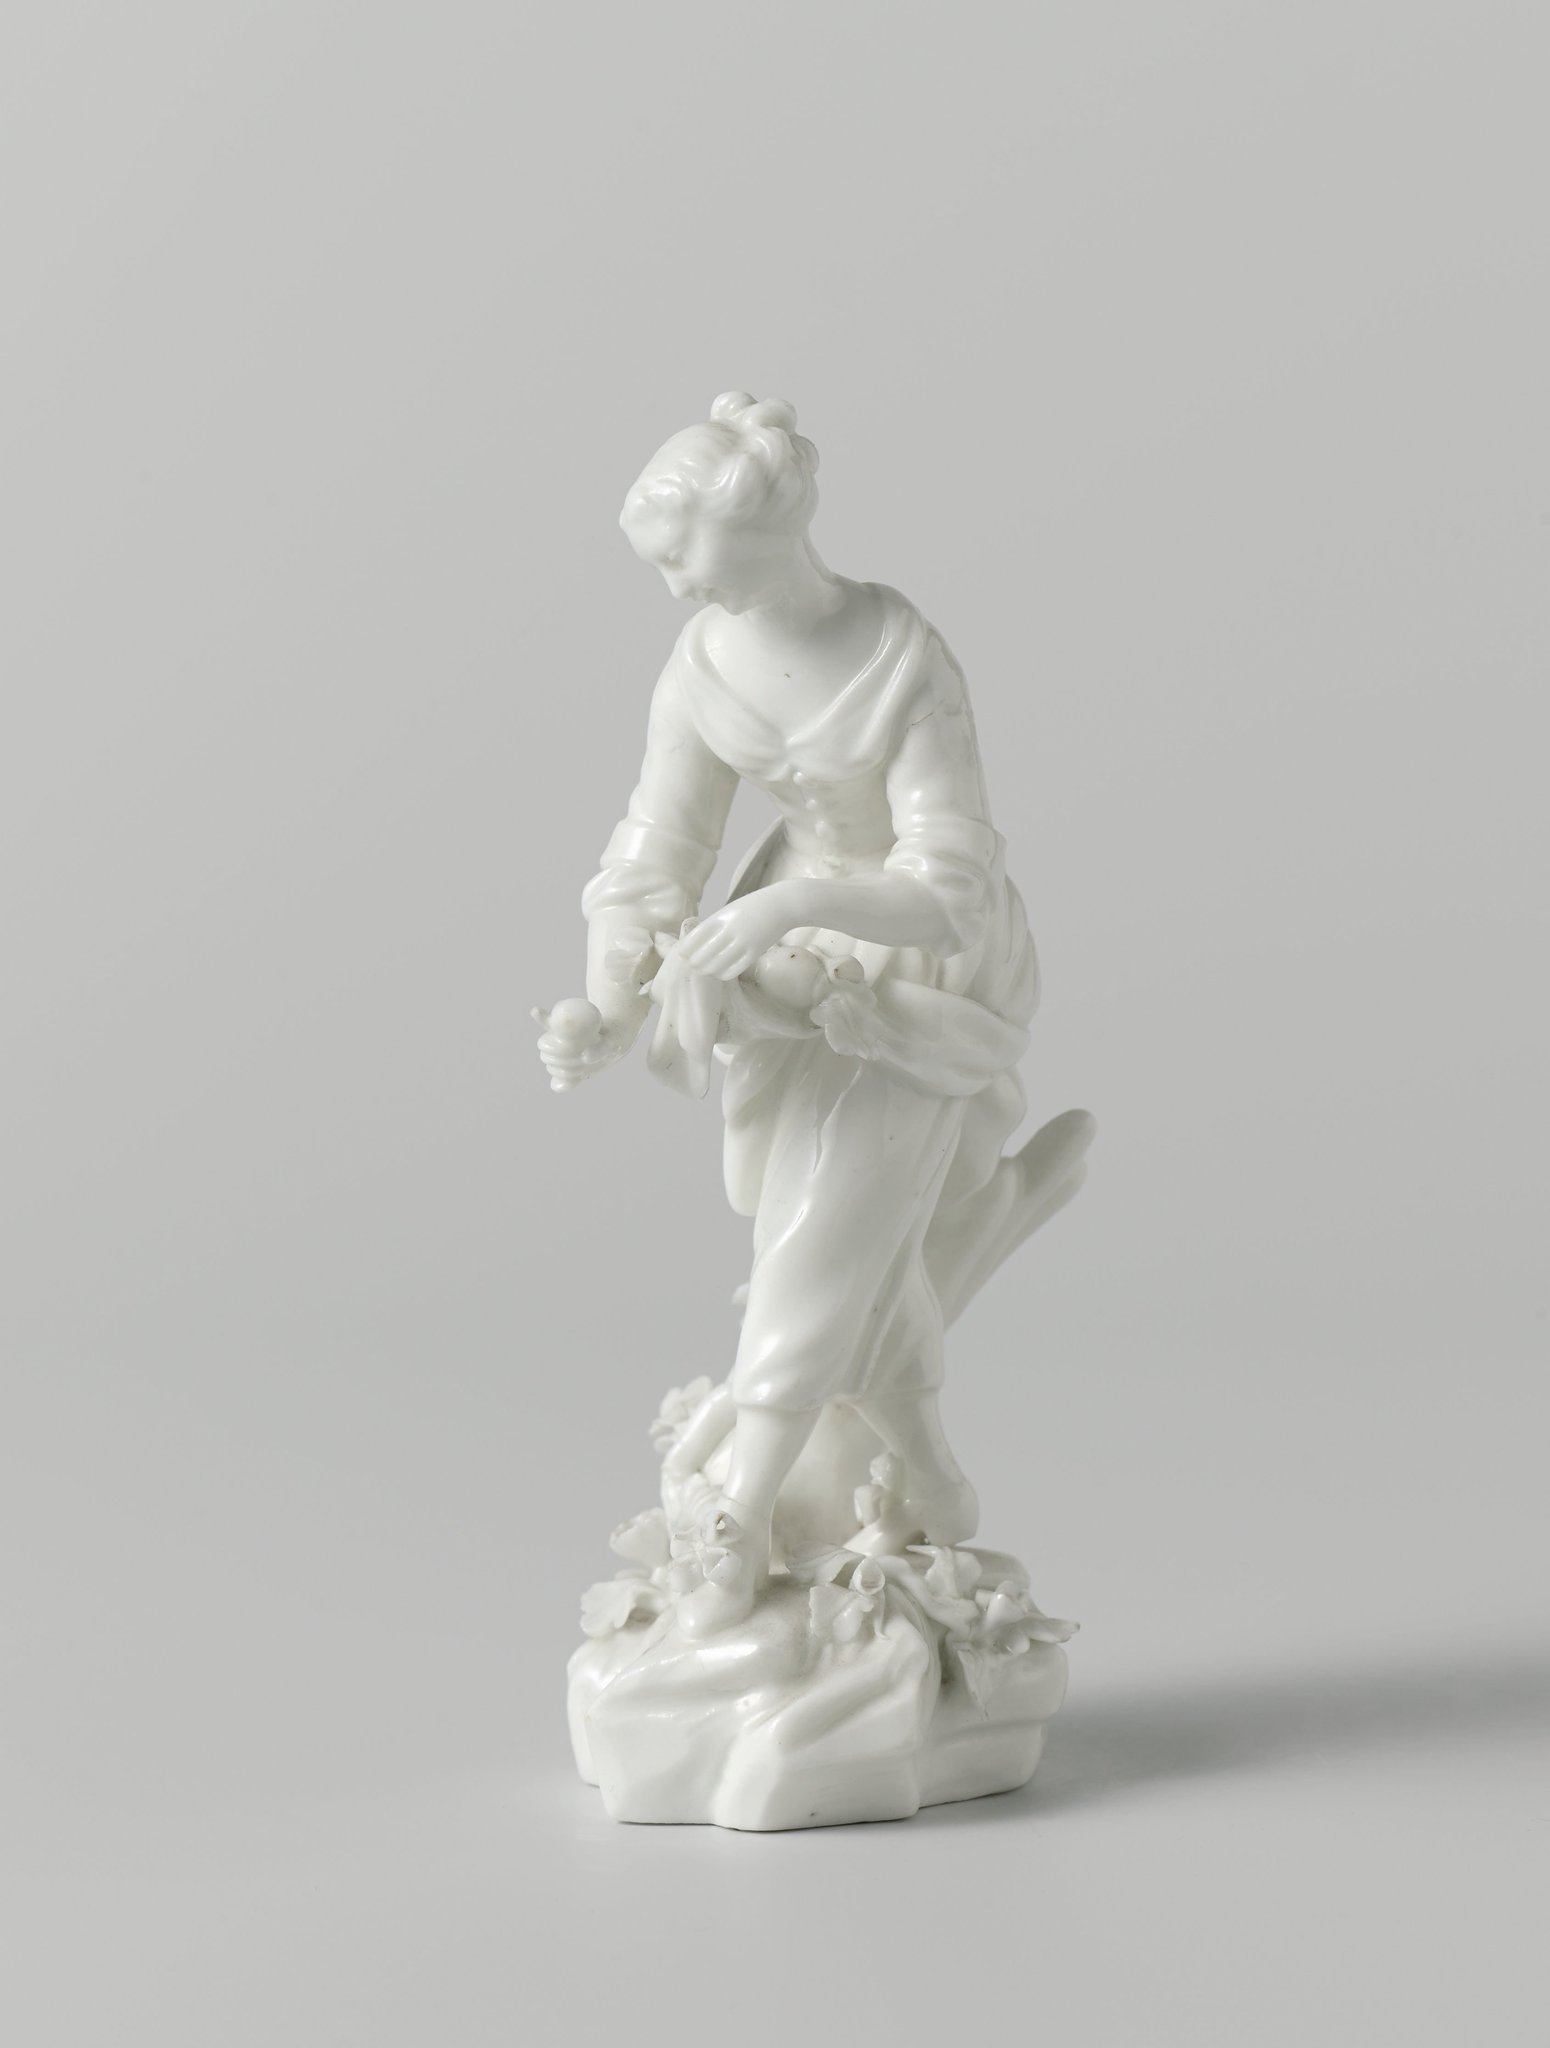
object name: figure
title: Figure of a fruit picking woman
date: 1755-1780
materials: glaze, paint, porcelain, soft paste porcelain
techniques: firing, forming, vitrification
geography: doornik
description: Two figures. Soft-paste porcelain. Tournai, c. 1755 - 1780, factory of François Joseph Peterinck.